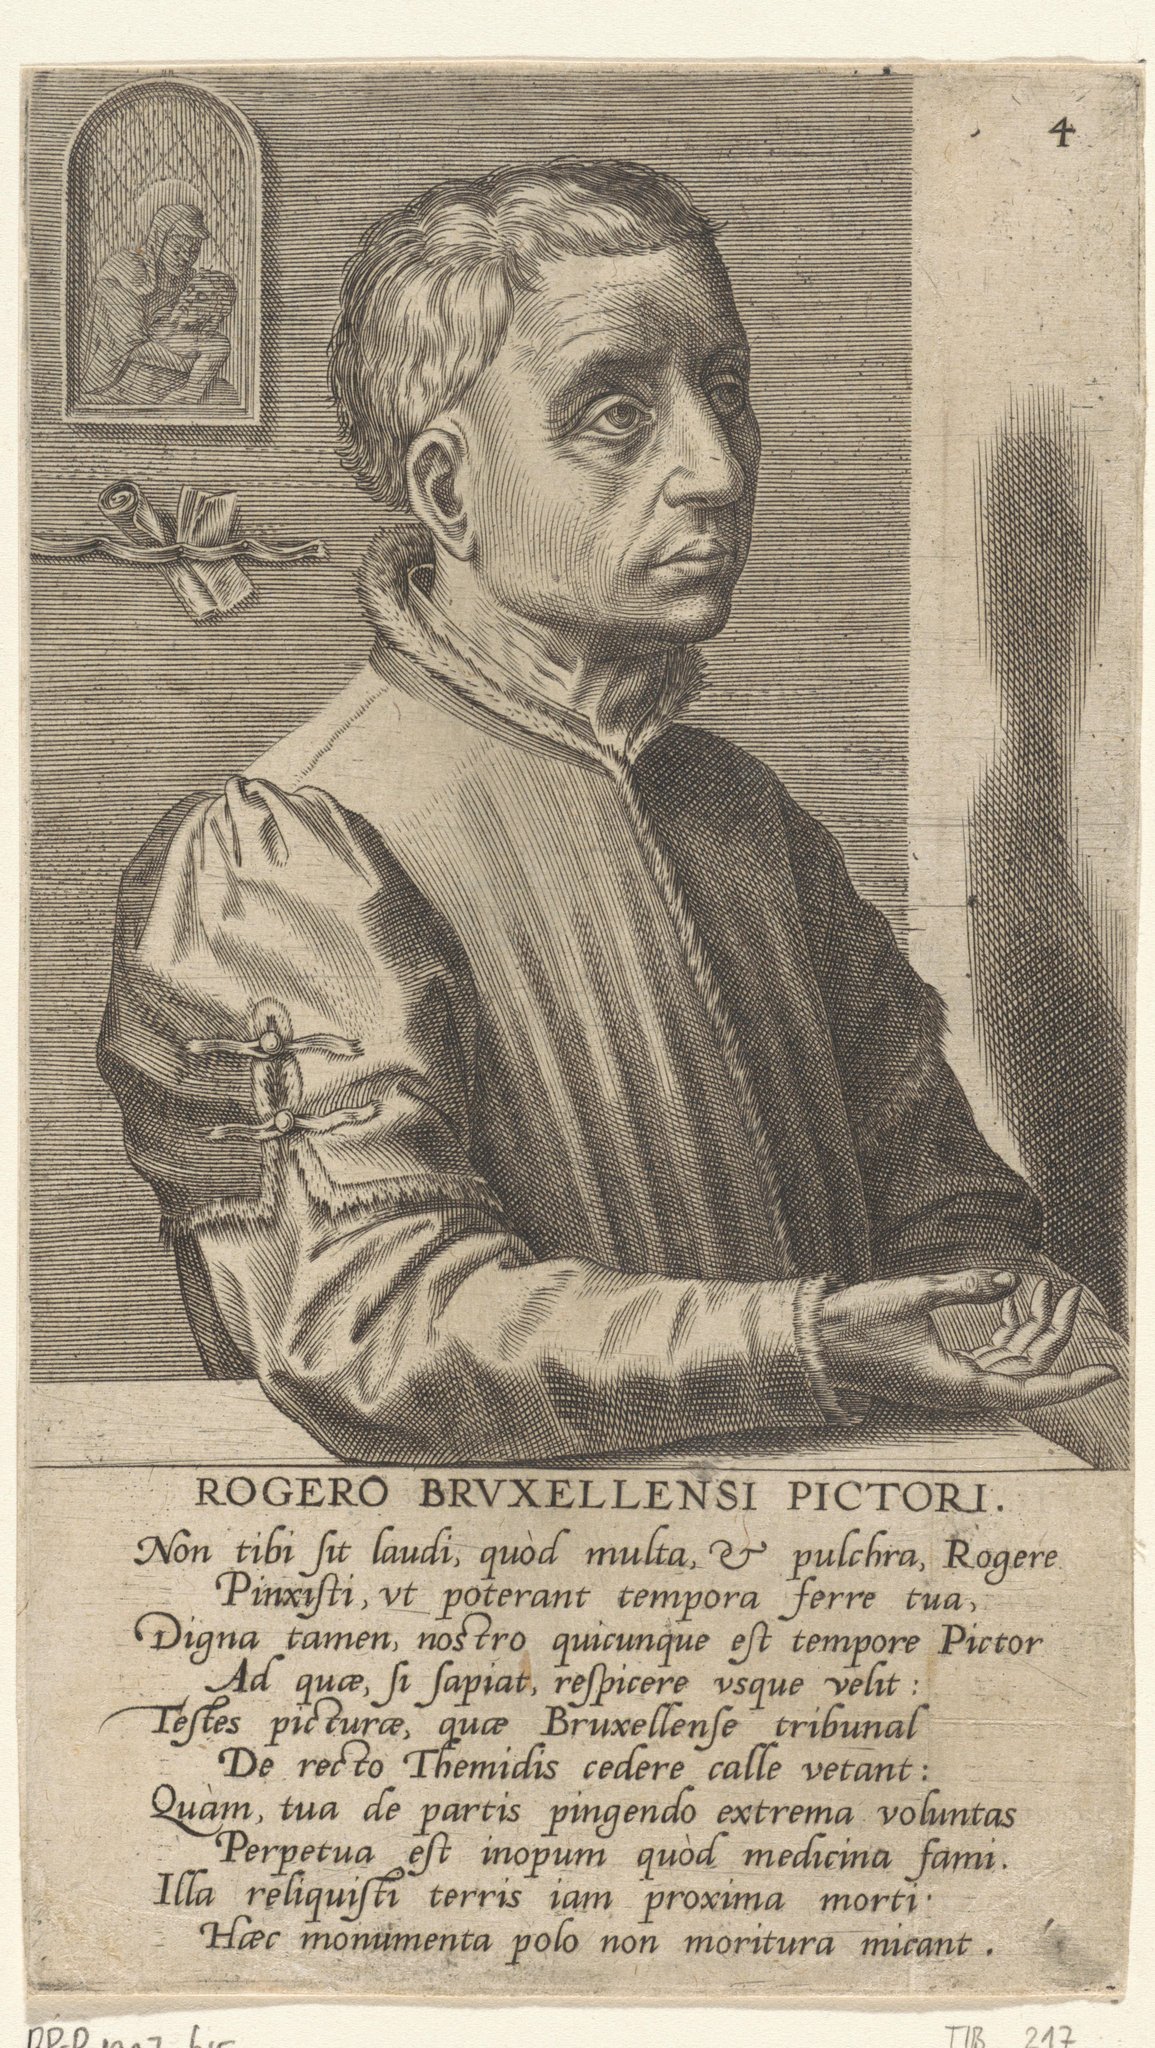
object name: print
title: Pictorum aliquot celebrium Germaniae Inferioris effigies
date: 1572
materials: paper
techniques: engraving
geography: antwerp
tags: brussels, painter, rogier van der weyden, portrait, self-portrait of painter, the dead christ in mary's lap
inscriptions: collector's mark: Lugt 2228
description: Aan de muur achter hem een schilderij van de piëta. In de marge een tienregelig onderschrift in het Latijn.